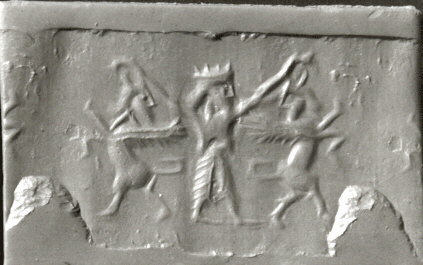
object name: cylinder seal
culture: achaemenid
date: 600-301 BCE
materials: marble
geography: iran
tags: men